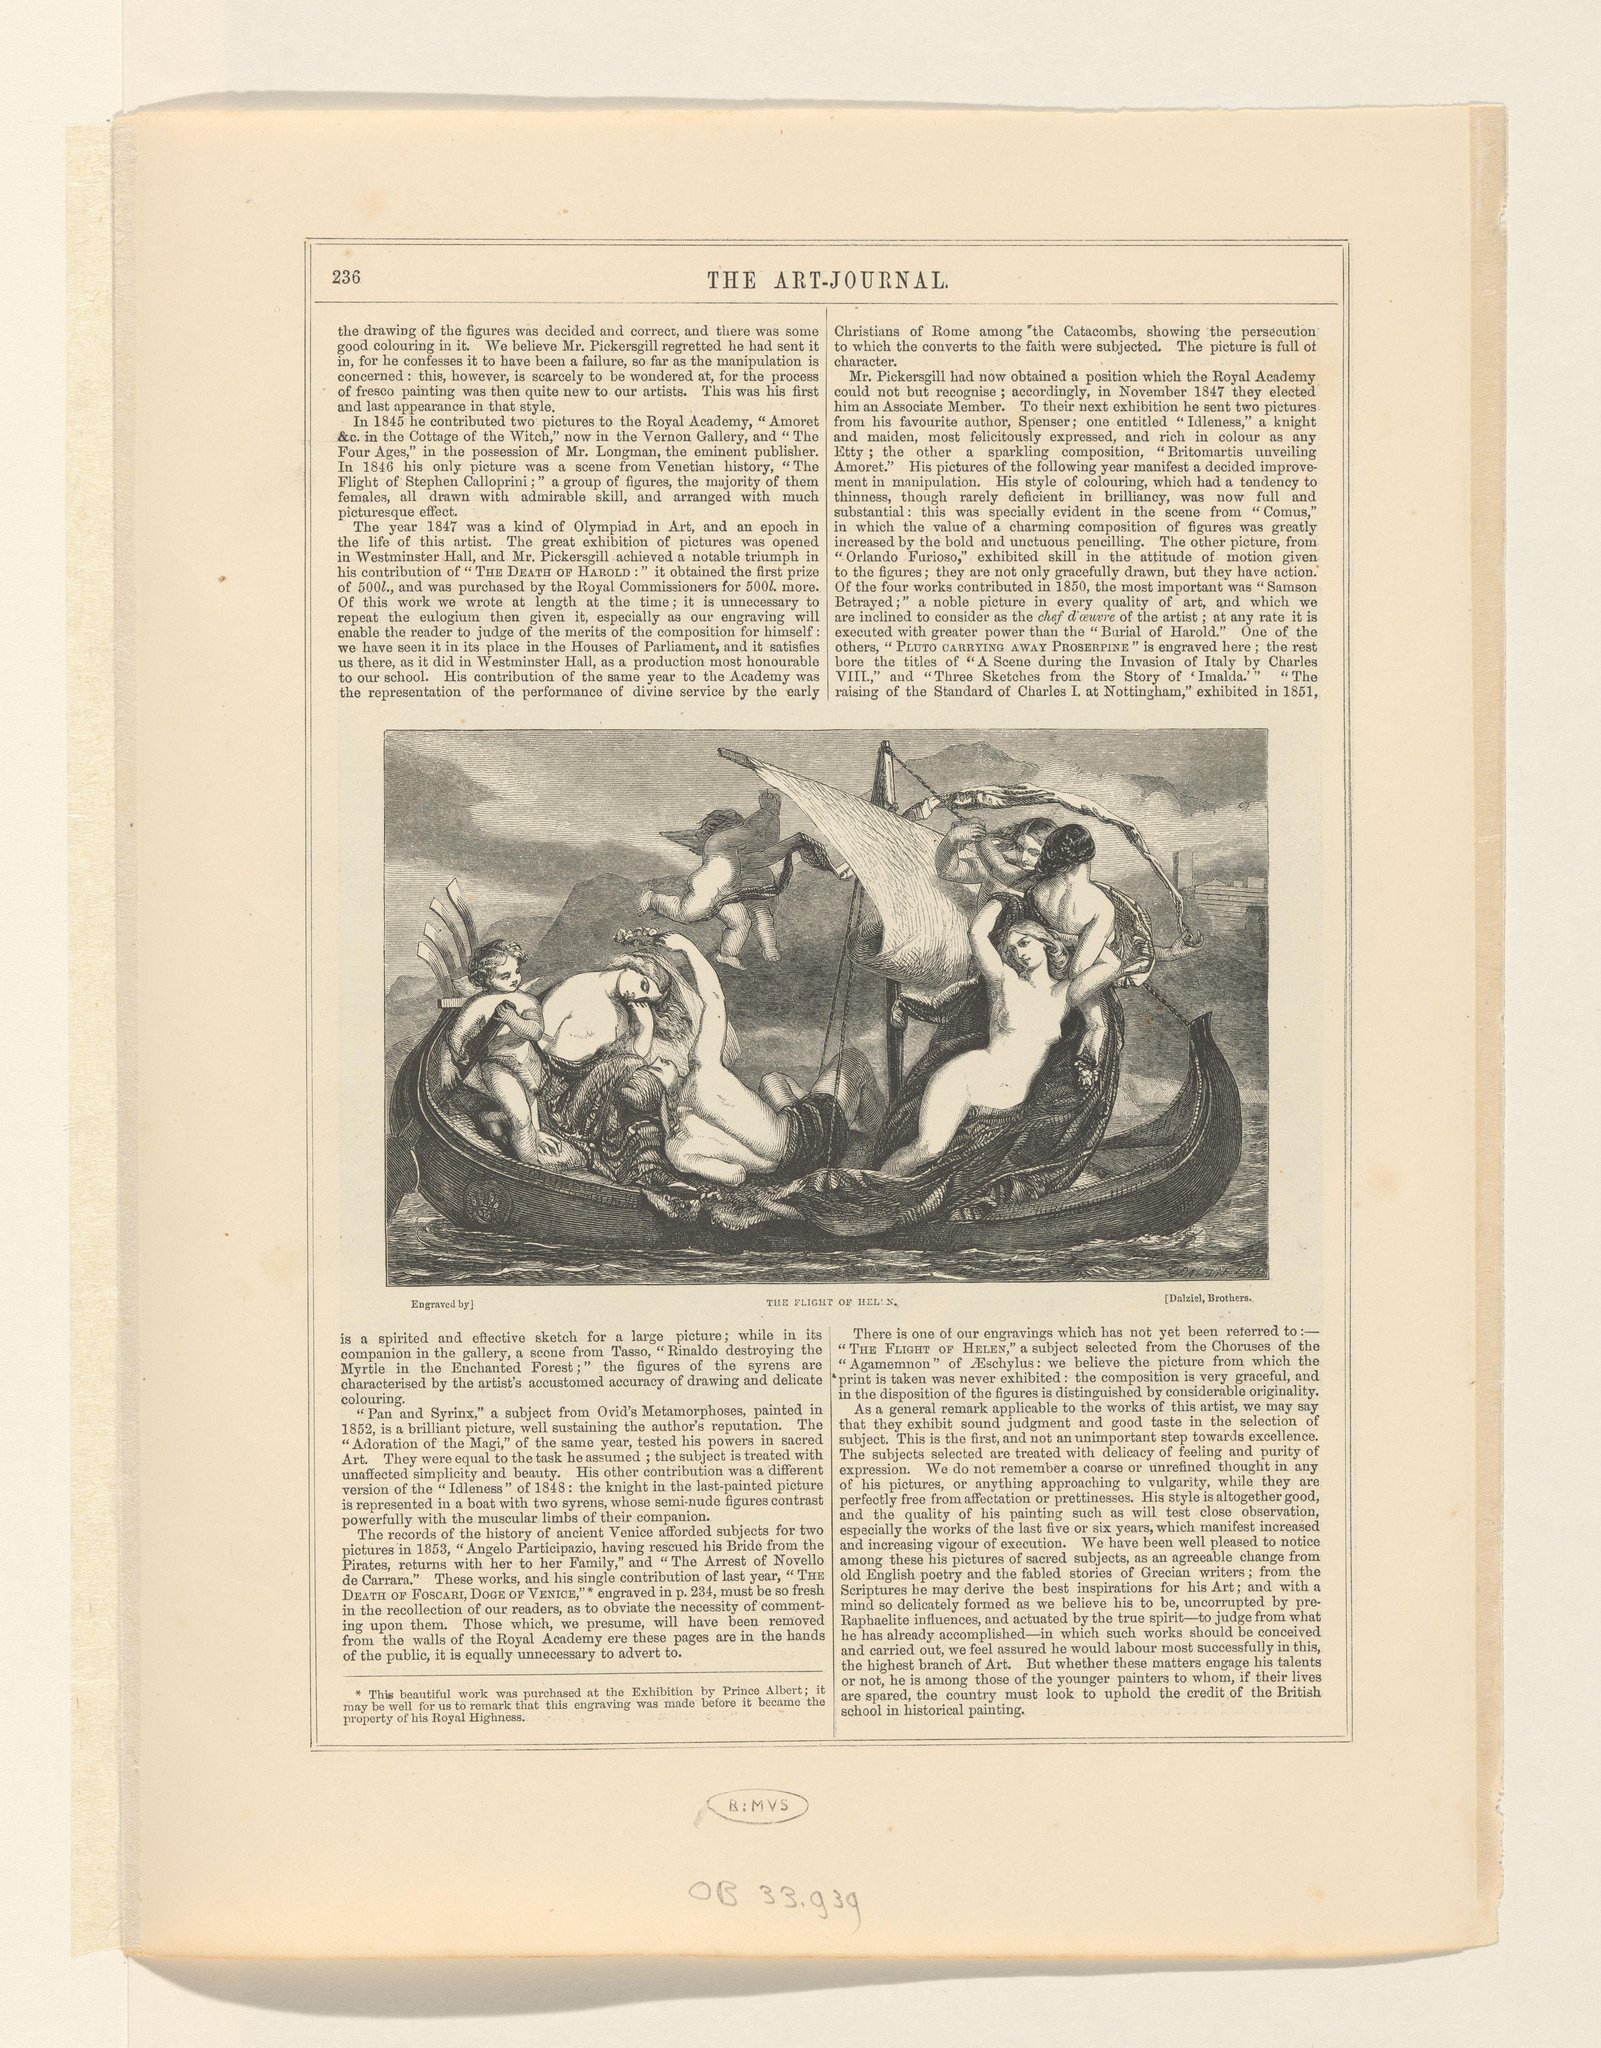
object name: print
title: Paris en Helena vluchten per boot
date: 1855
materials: paper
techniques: letterpress printing, engraving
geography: london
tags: the arrival of paris and helen at troy, the abduction of helen and some of her companions: paris carries them off by sea, and takes a part of the palace-treasure with him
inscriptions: collector's mark: Lugt 2228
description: Prent uit: The Art Journal 4 (1855), p. 236.